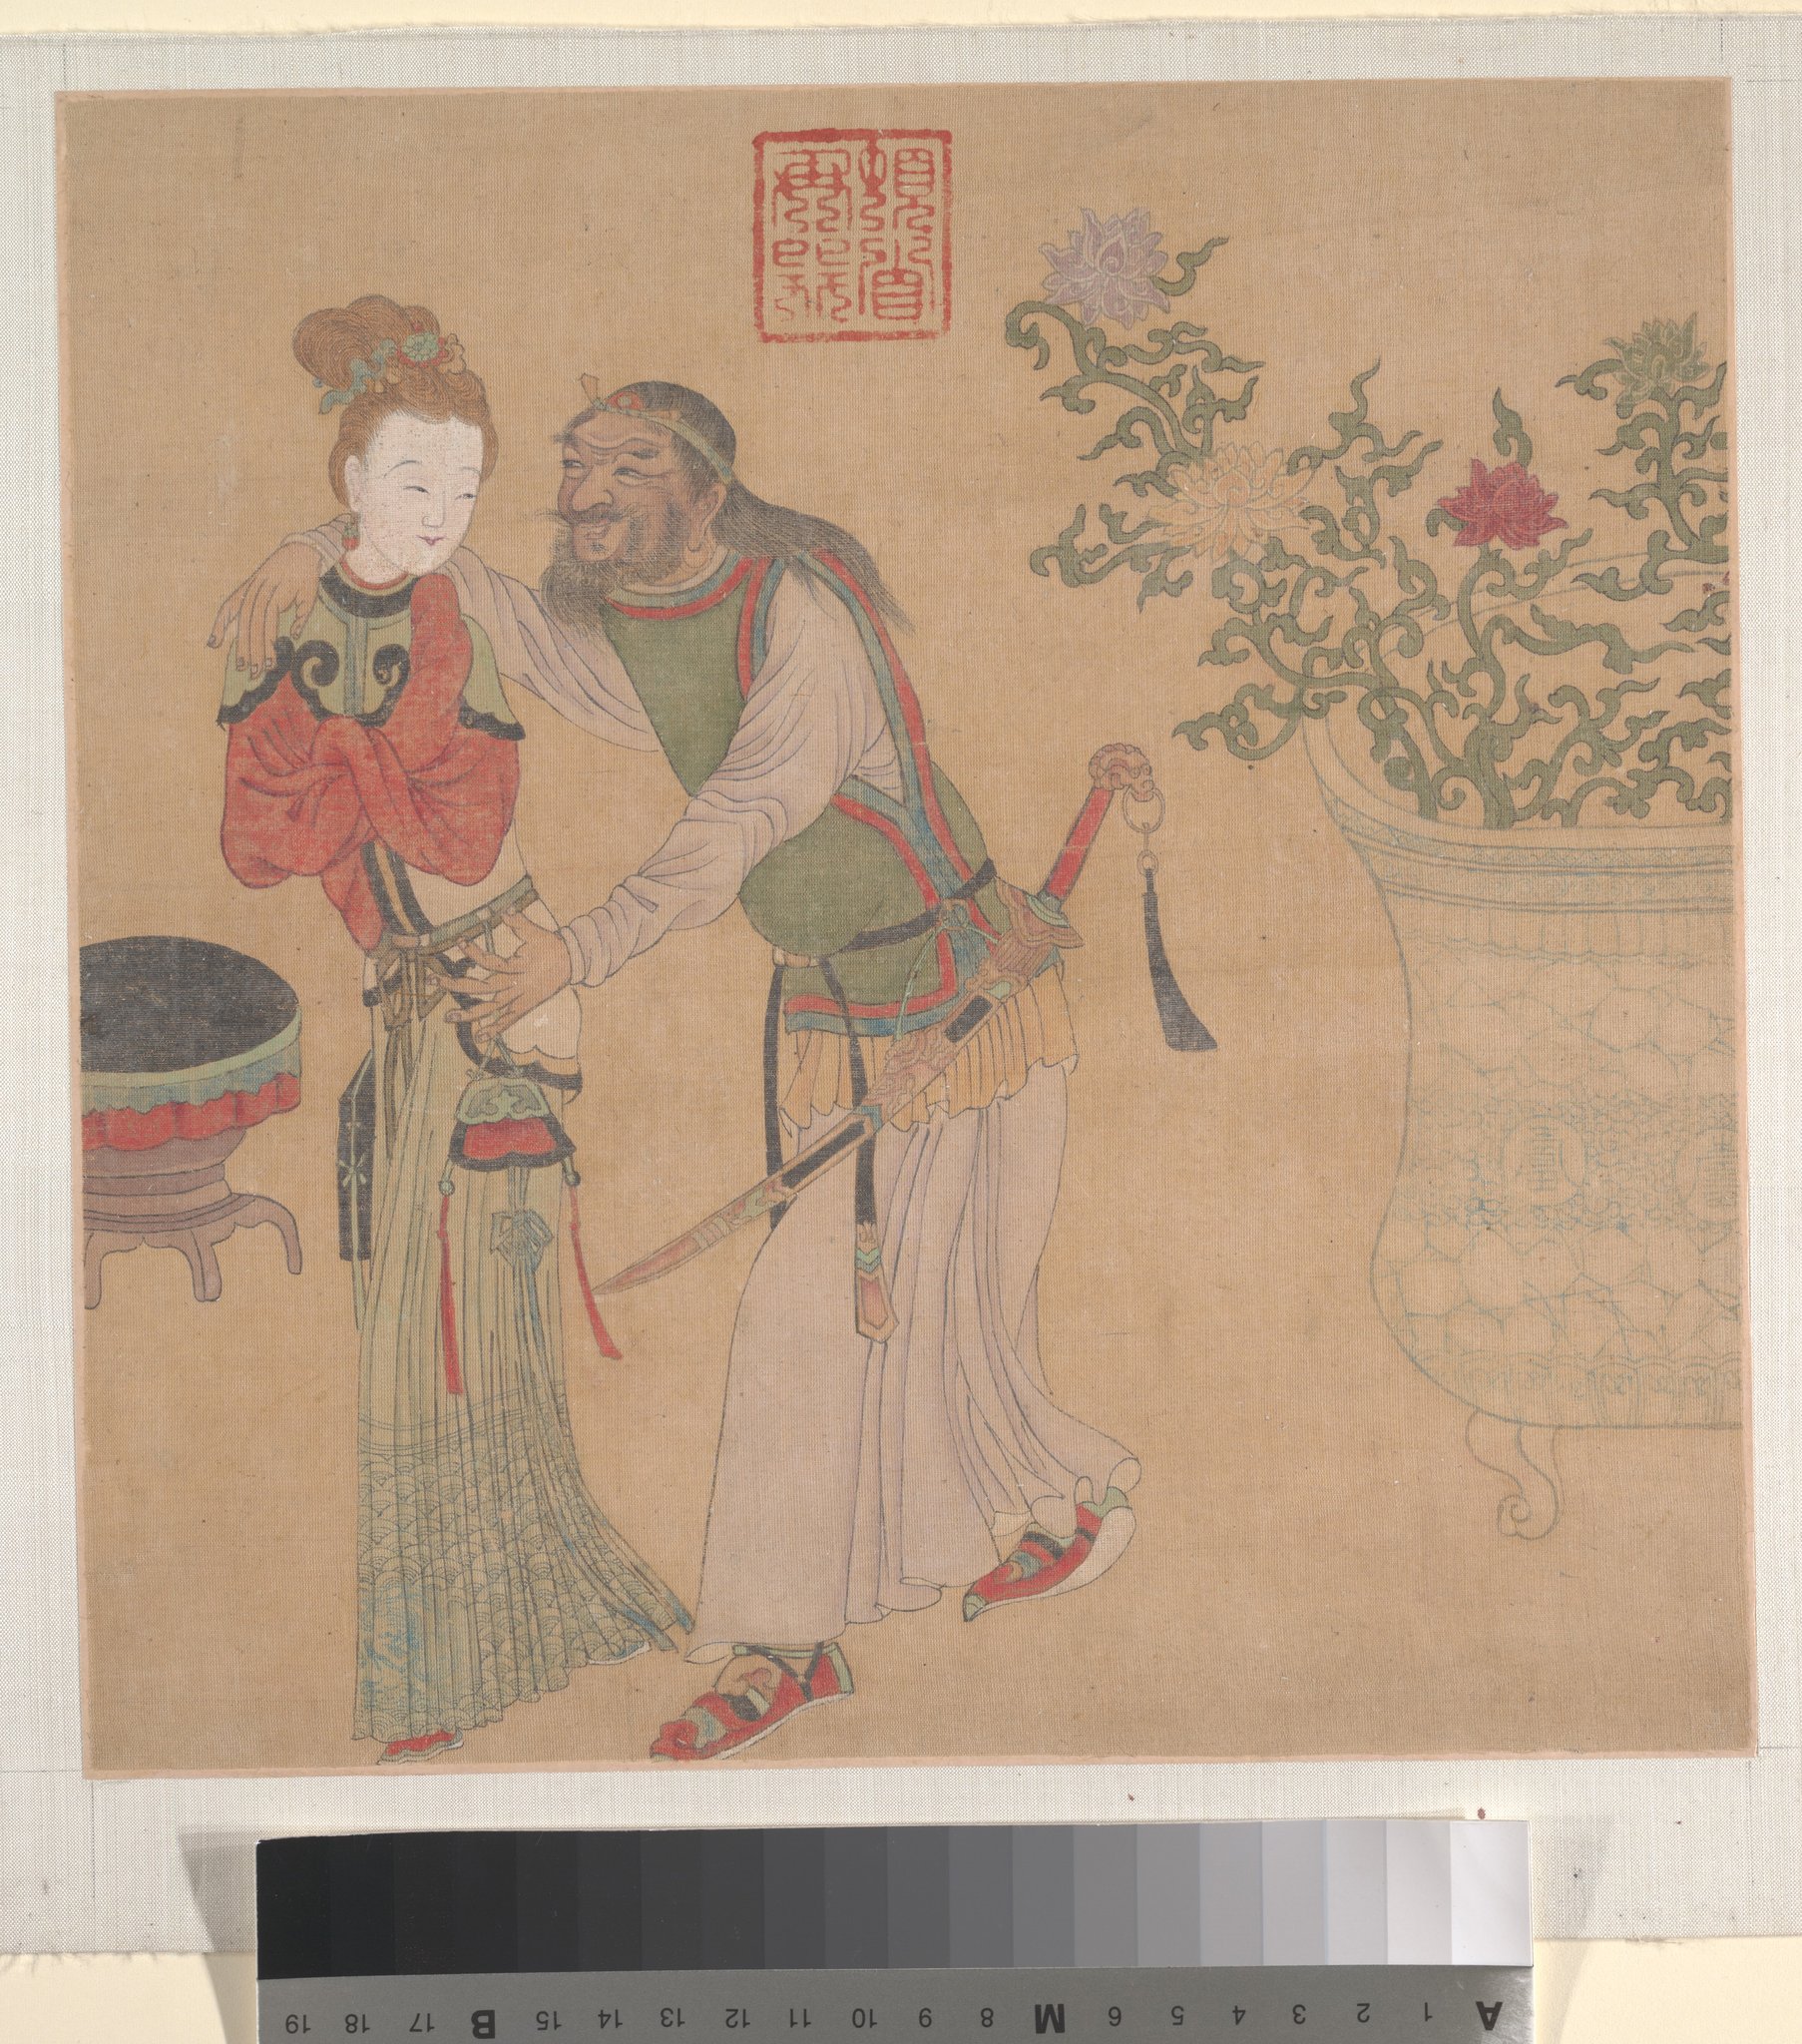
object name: album leaf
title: Tartar Officer Courting Blond Lady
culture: chinese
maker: unidentified artist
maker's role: artist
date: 1644-1911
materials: ink, silk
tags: swords,men,women